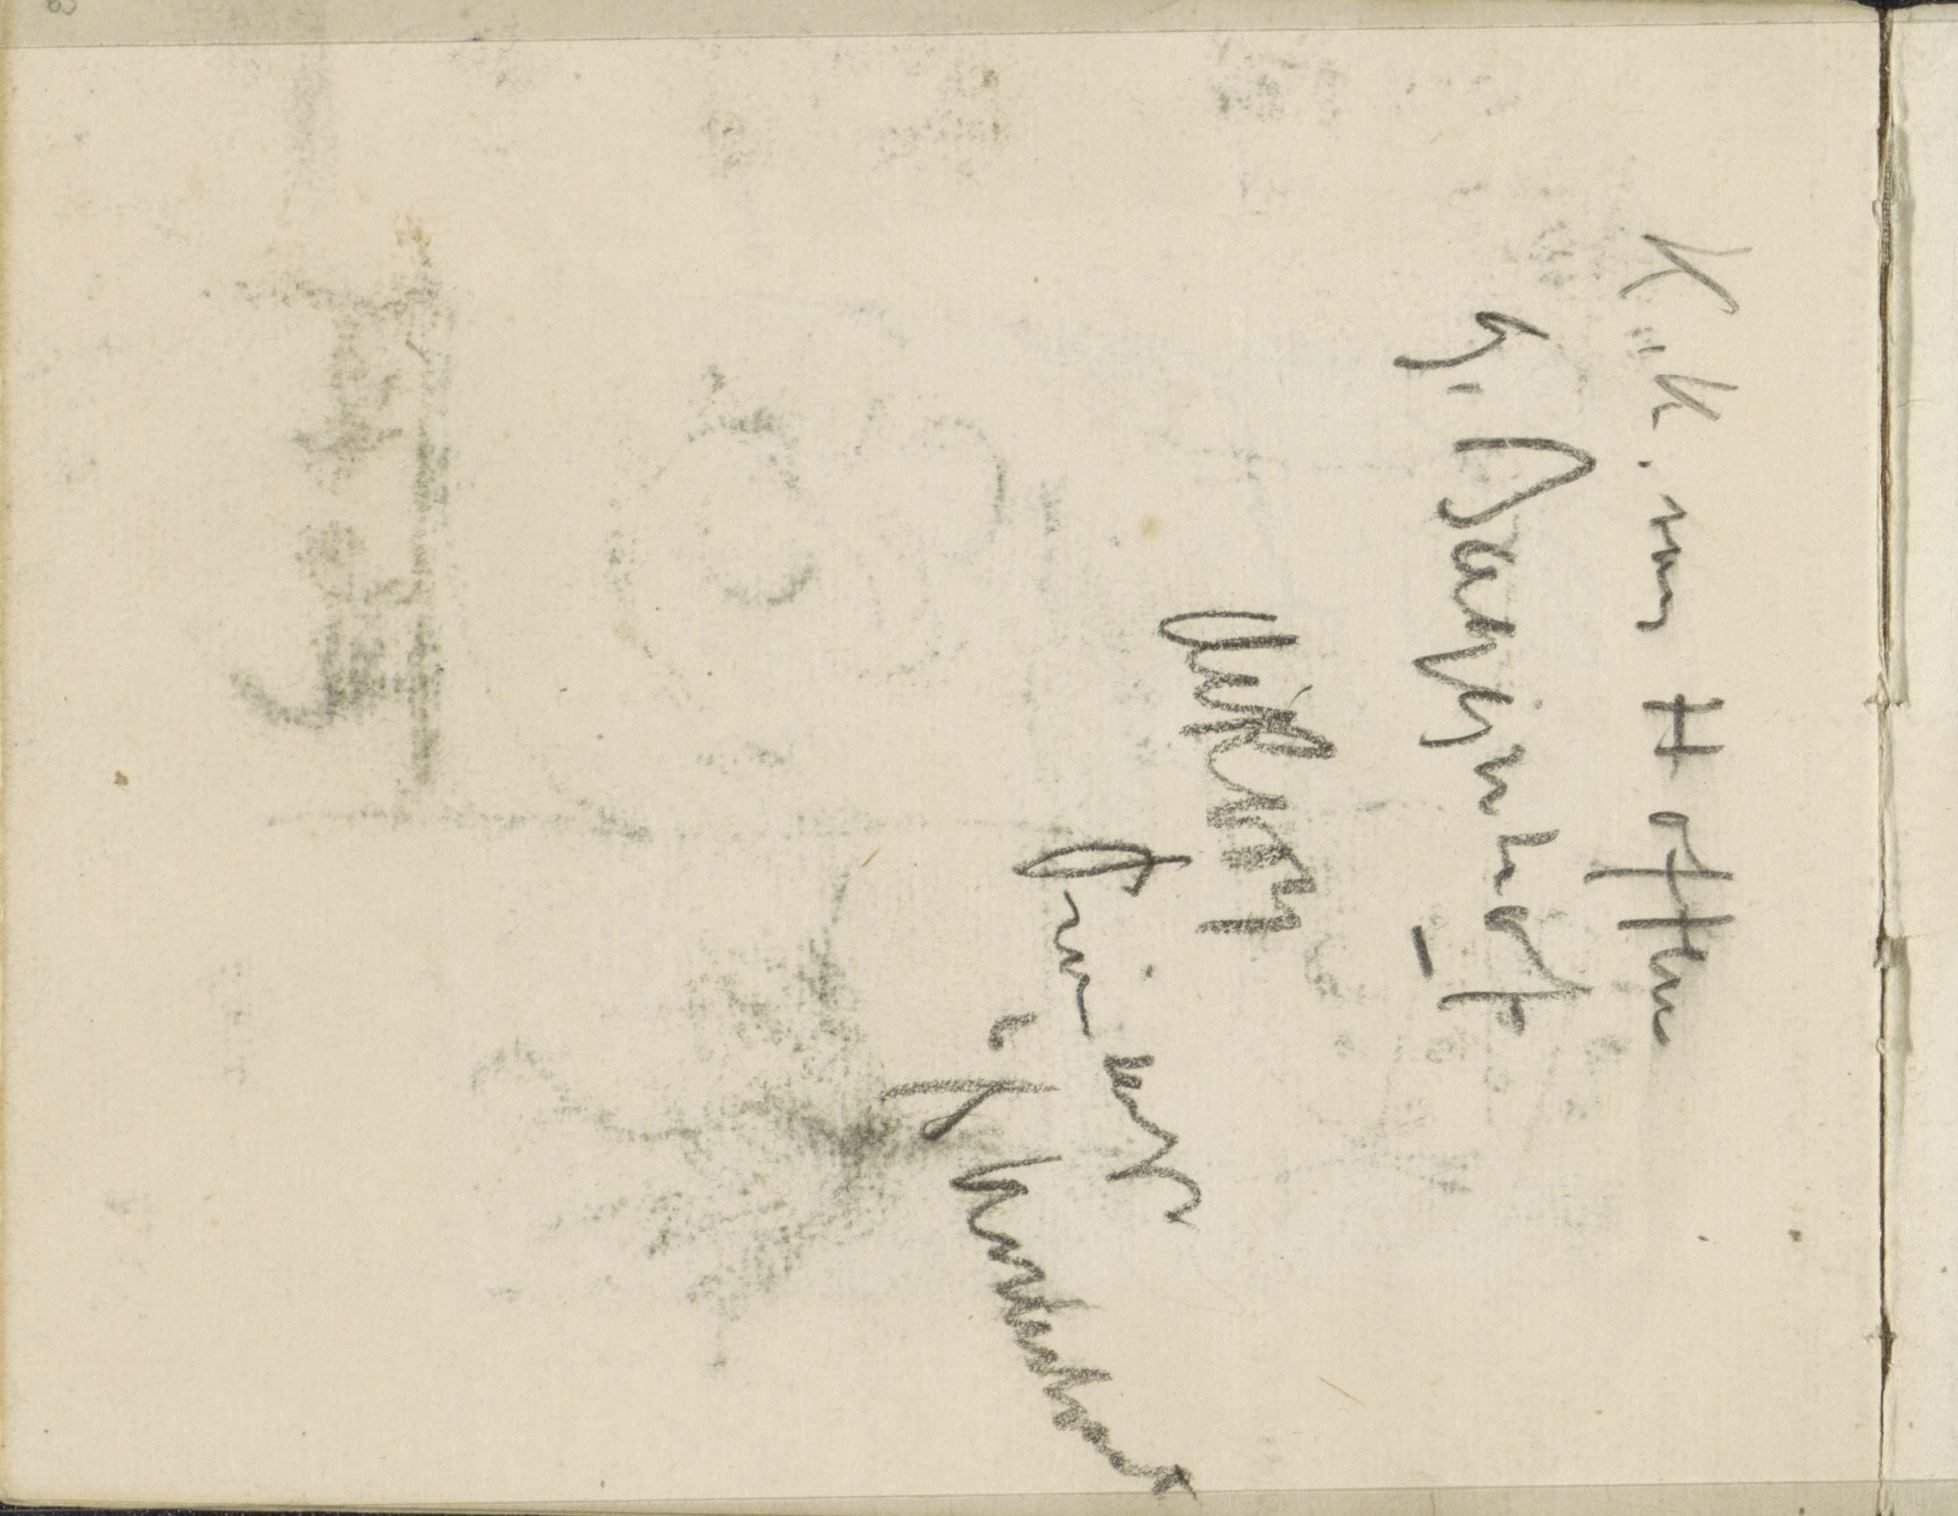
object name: sketchbook leaf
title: Annotaties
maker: george hendrik breitner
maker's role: draughtsman, painter, print maker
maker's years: 1857-1923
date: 1885-1898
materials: chalk, paper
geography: amsterdam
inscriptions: annotation: ‘K.K. van Hoffen/ 9. Bagijnhof/ de Rooij/ Prinsengr/ b/d Hartenstraat’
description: Pagina 65 uit een schetsboek met 32 bladen.